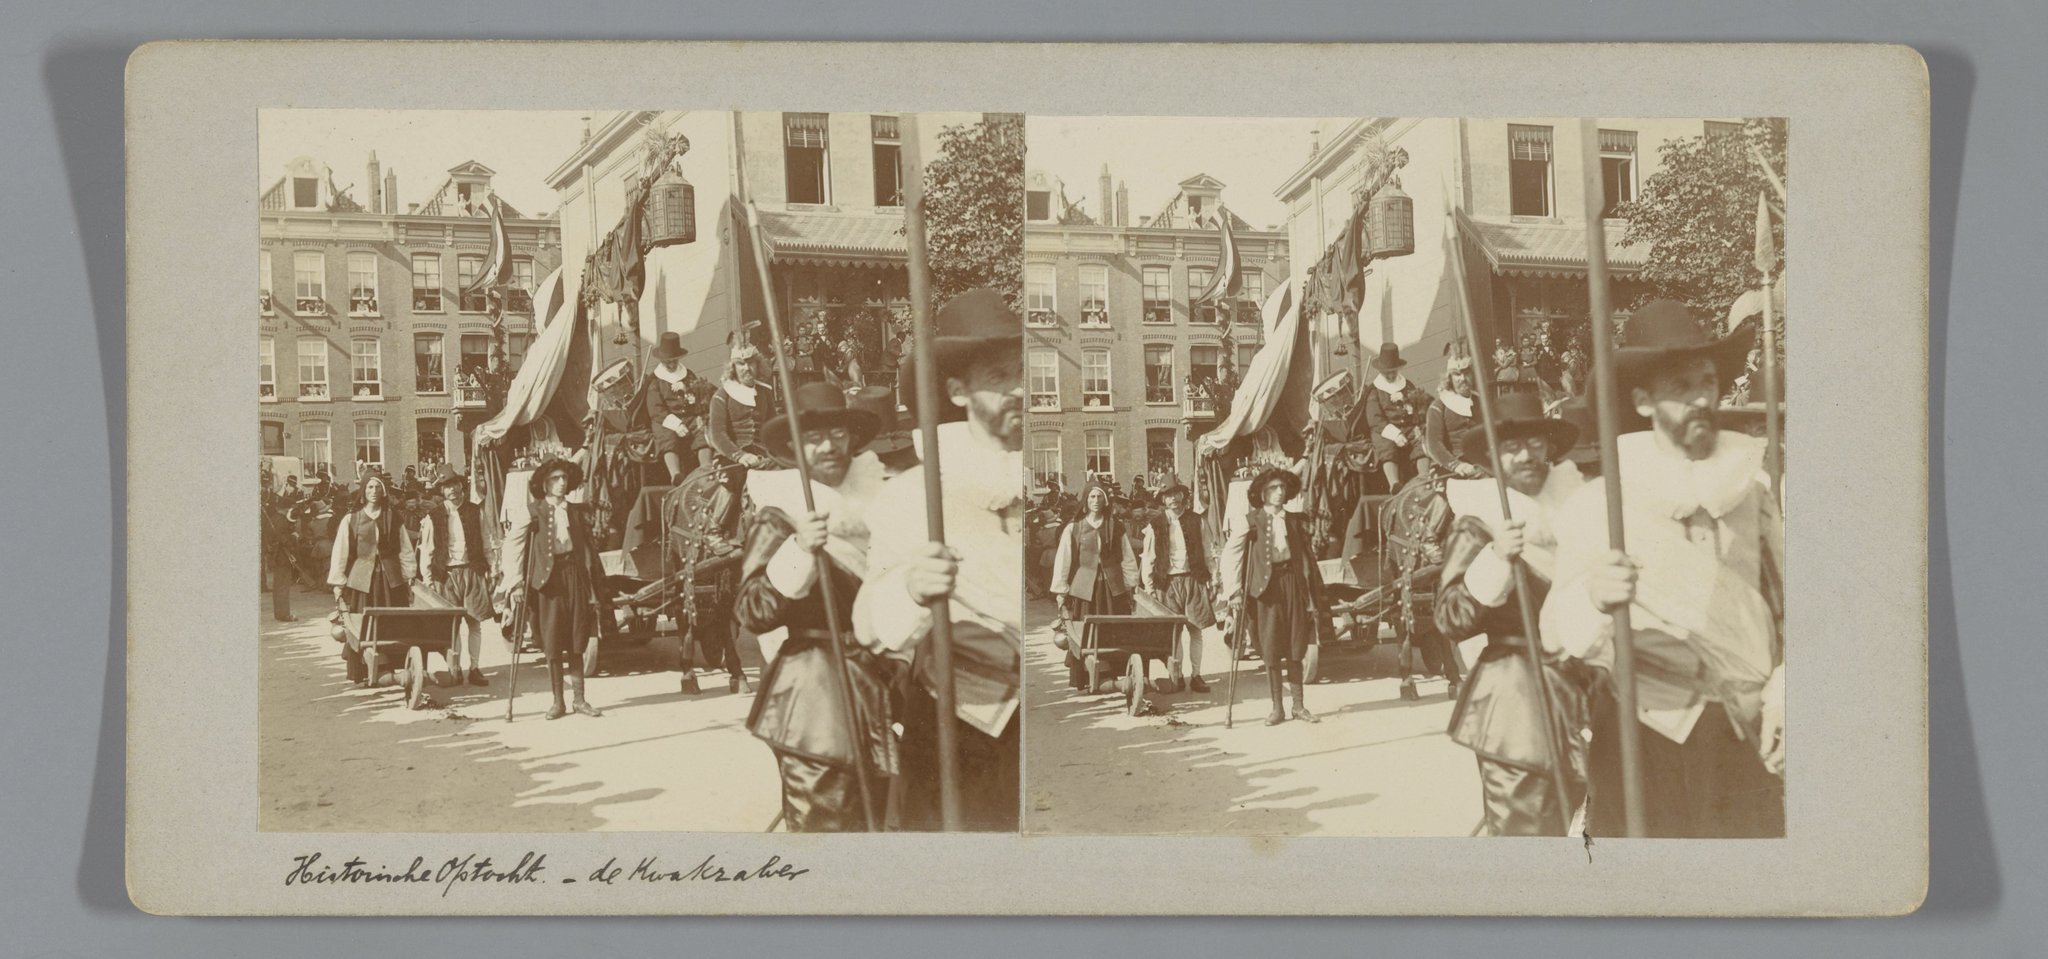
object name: stereograph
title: Kwakzalver van de historische en allegorische optocht, ter gelegenheid van de inhuldiging van koningin Wilhelmina, Amsterdam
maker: Anonymous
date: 1898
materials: paper, cardboard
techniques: gelatin silver print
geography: amsterdam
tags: the hague, print maker, wilhelmina of the netherlands, ceremonial celebration of installation of a ruler, amsterdam